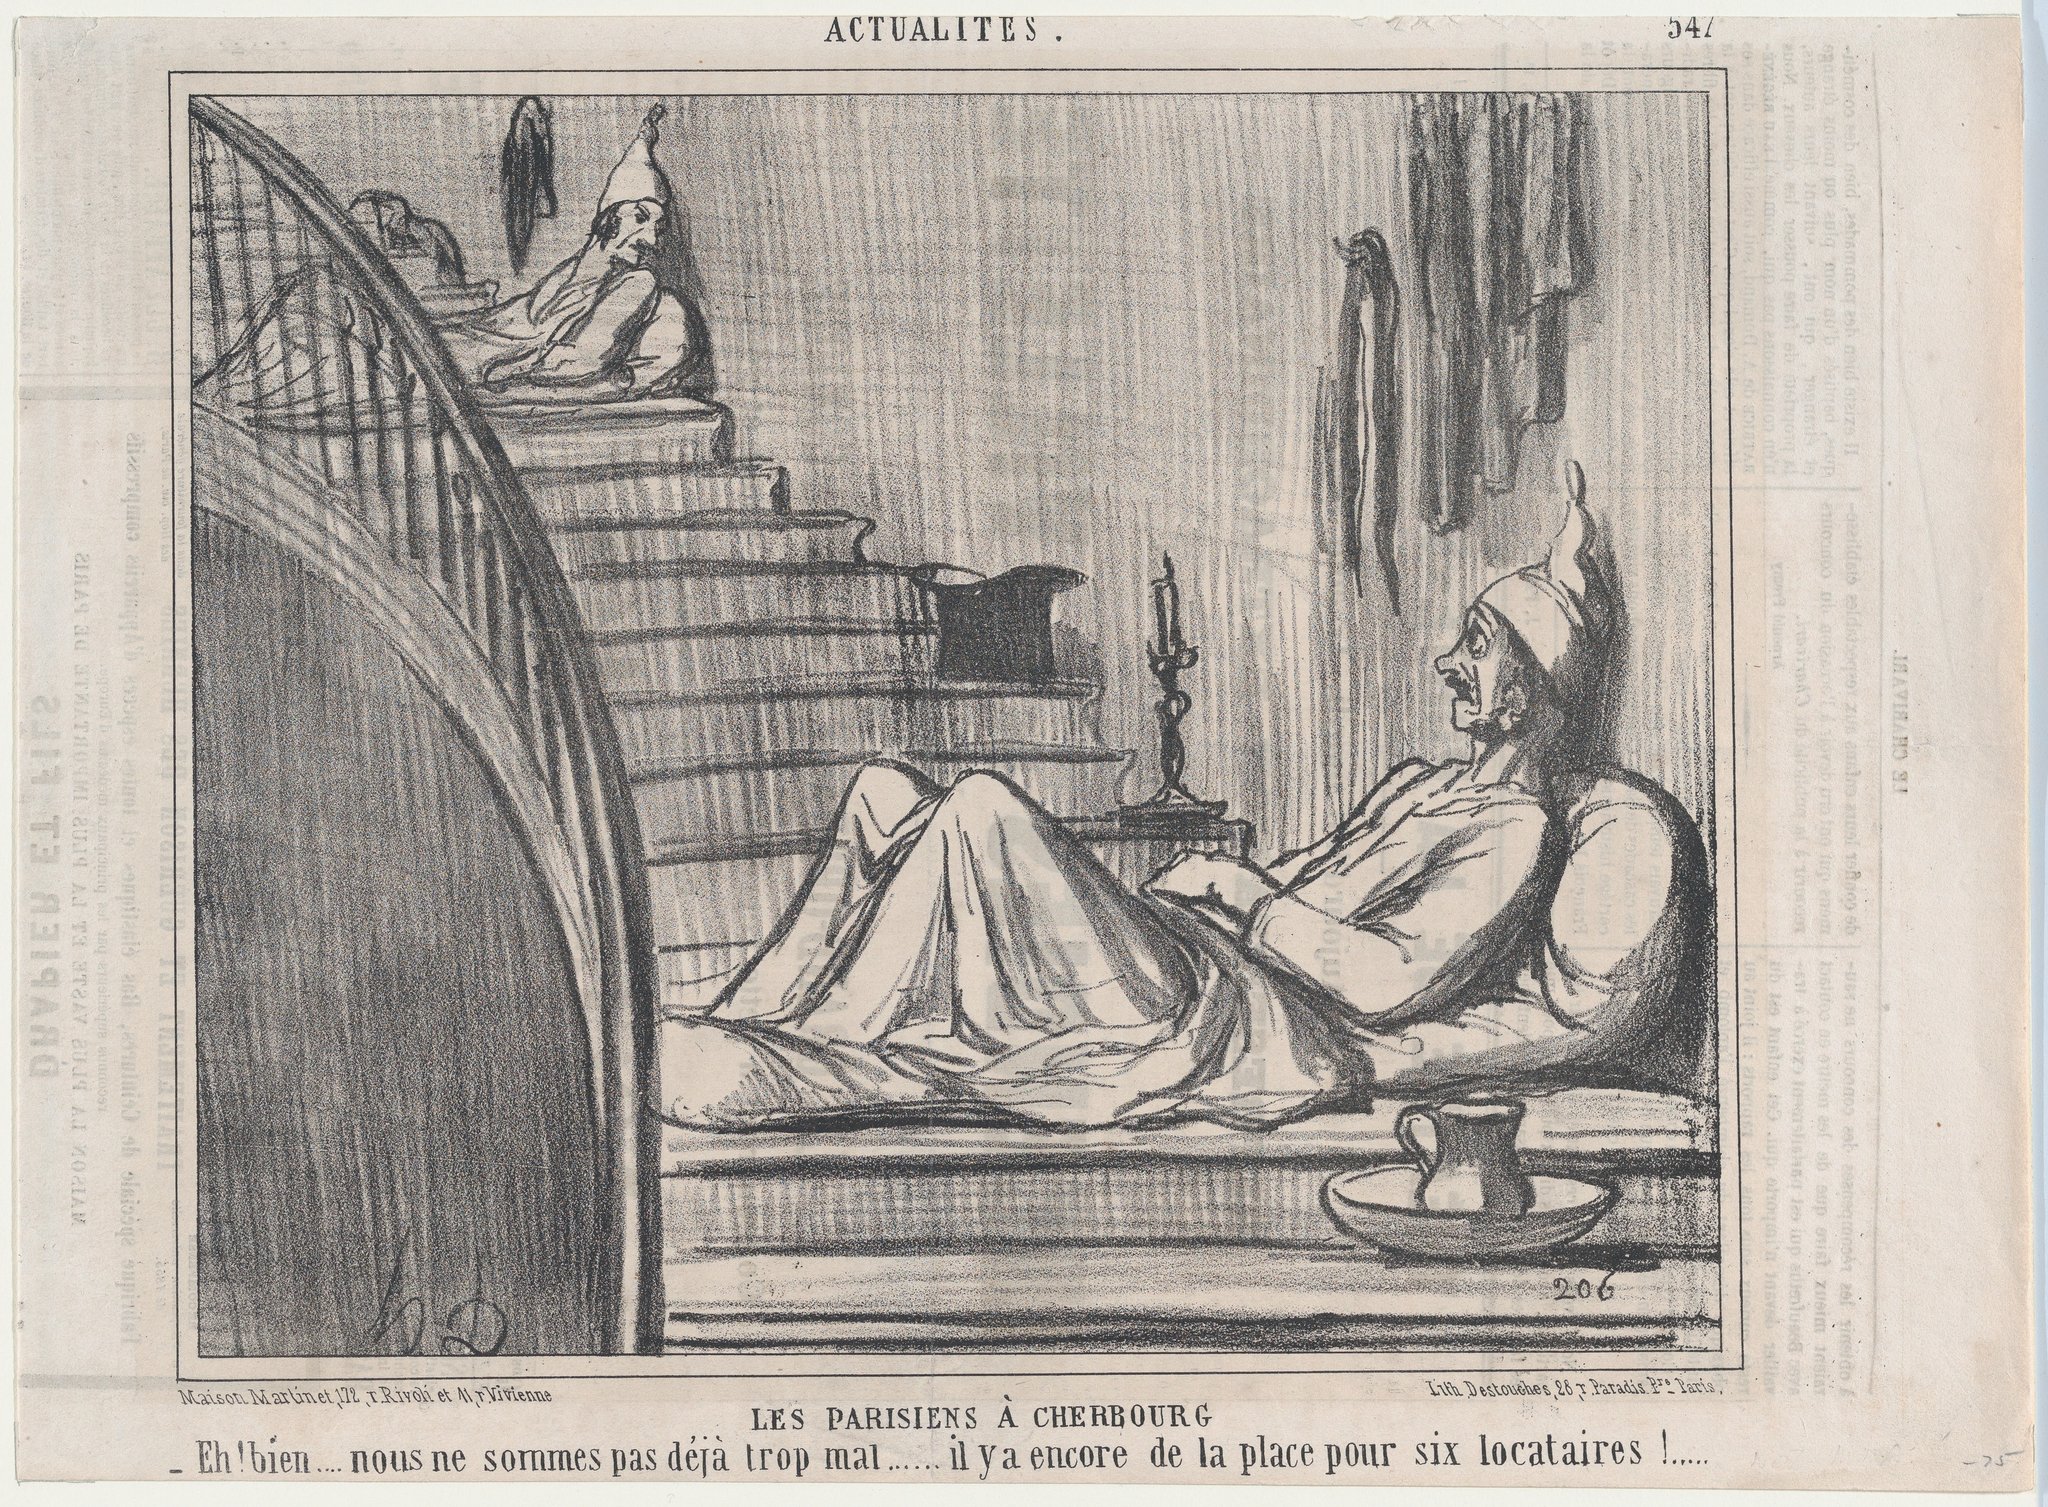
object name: print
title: Les Parisiens à Cherbourg, from Actualités, published in Le Charivari, August 16-17, 1858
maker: honoré daumier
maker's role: artist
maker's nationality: french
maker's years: 1808-1879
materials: paper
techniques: lithograph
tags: satire,men